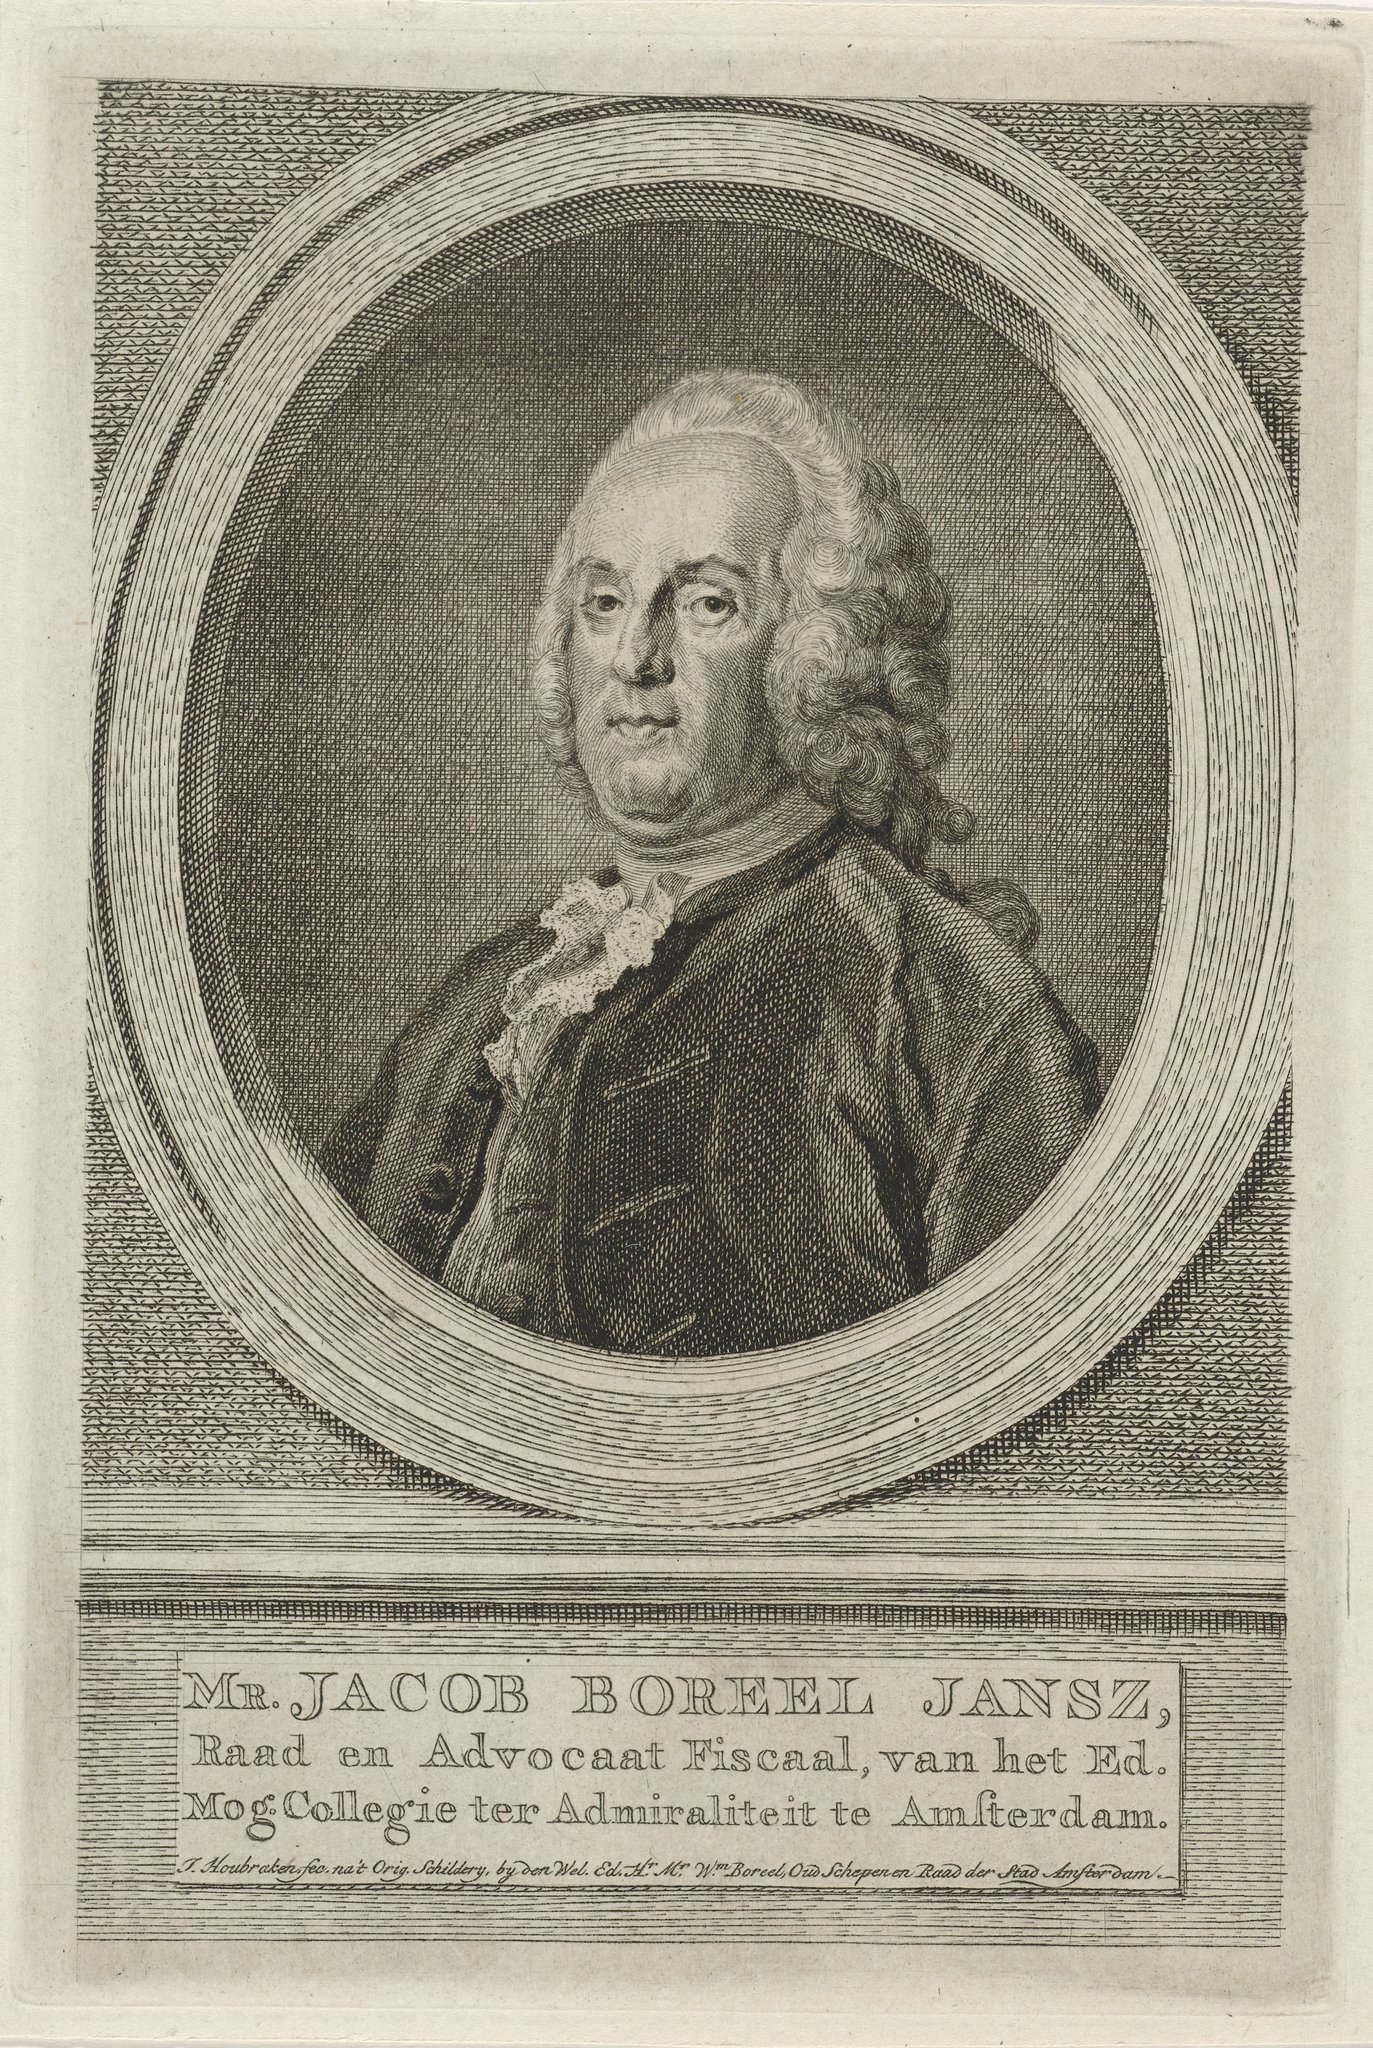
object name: print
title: Portret van Jacob Boreel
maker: jacob houbraken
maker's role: draughtsman, print maker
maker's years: 1698-1780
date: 1749-1780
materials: paper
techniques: engraving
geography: amsterdam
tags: historical persons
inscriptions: collector's mark: Lugt 2228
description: Deze prent is oorspronkelijk bedoeld als aanvulling op Jan Wagenaars ‘Vaderlandsche historie’* en was zo vanaf 1796 verkrijgbaar bij Johannes Allart te Amsterdam. Voor de advertentie waarin Allart de 60 portretten en 7 platen, allen gegraveerd door Houbraken, ter aanvulling op Wagenaars ‘Vaderlandsche historie’ aanbiedt, zie RP-P-OB-77.766. *Van dit werk zijn in de achttiende eeuw meerdere uitgaves verschenen, zoals: Wagenaar, Jan. Vaderlandsche historie, vervattende de geschiedenissen der Vereenigde Nederlanden (…). 21 delen. Amsterdam: Isaak Tirion, 1749-1759. Wagenaar, Jan. Vaderlandsche historie, vervattende de geschiedenissen der nu Vereenigde Nederlanden (…). 21 delen. Amsterdam: weduwe Isaak Tirion, 1770. Wagenaar, Jan. Vaderlandsche historie, vervattende de geschiedenissen der nu Vereenigde Nederlanden (…). 21 delen. Amsterdam, Leiden, Dordrecht en Harlingen: P. Schouten e.a., 1782. Wagenaar, Jan. Vaderlandsche historie, vervattende de geschiedenissen der nu Vereenigde Nederlanden (…). 21 delen. Amsterdam: Johannes Allart, 1790-1796.